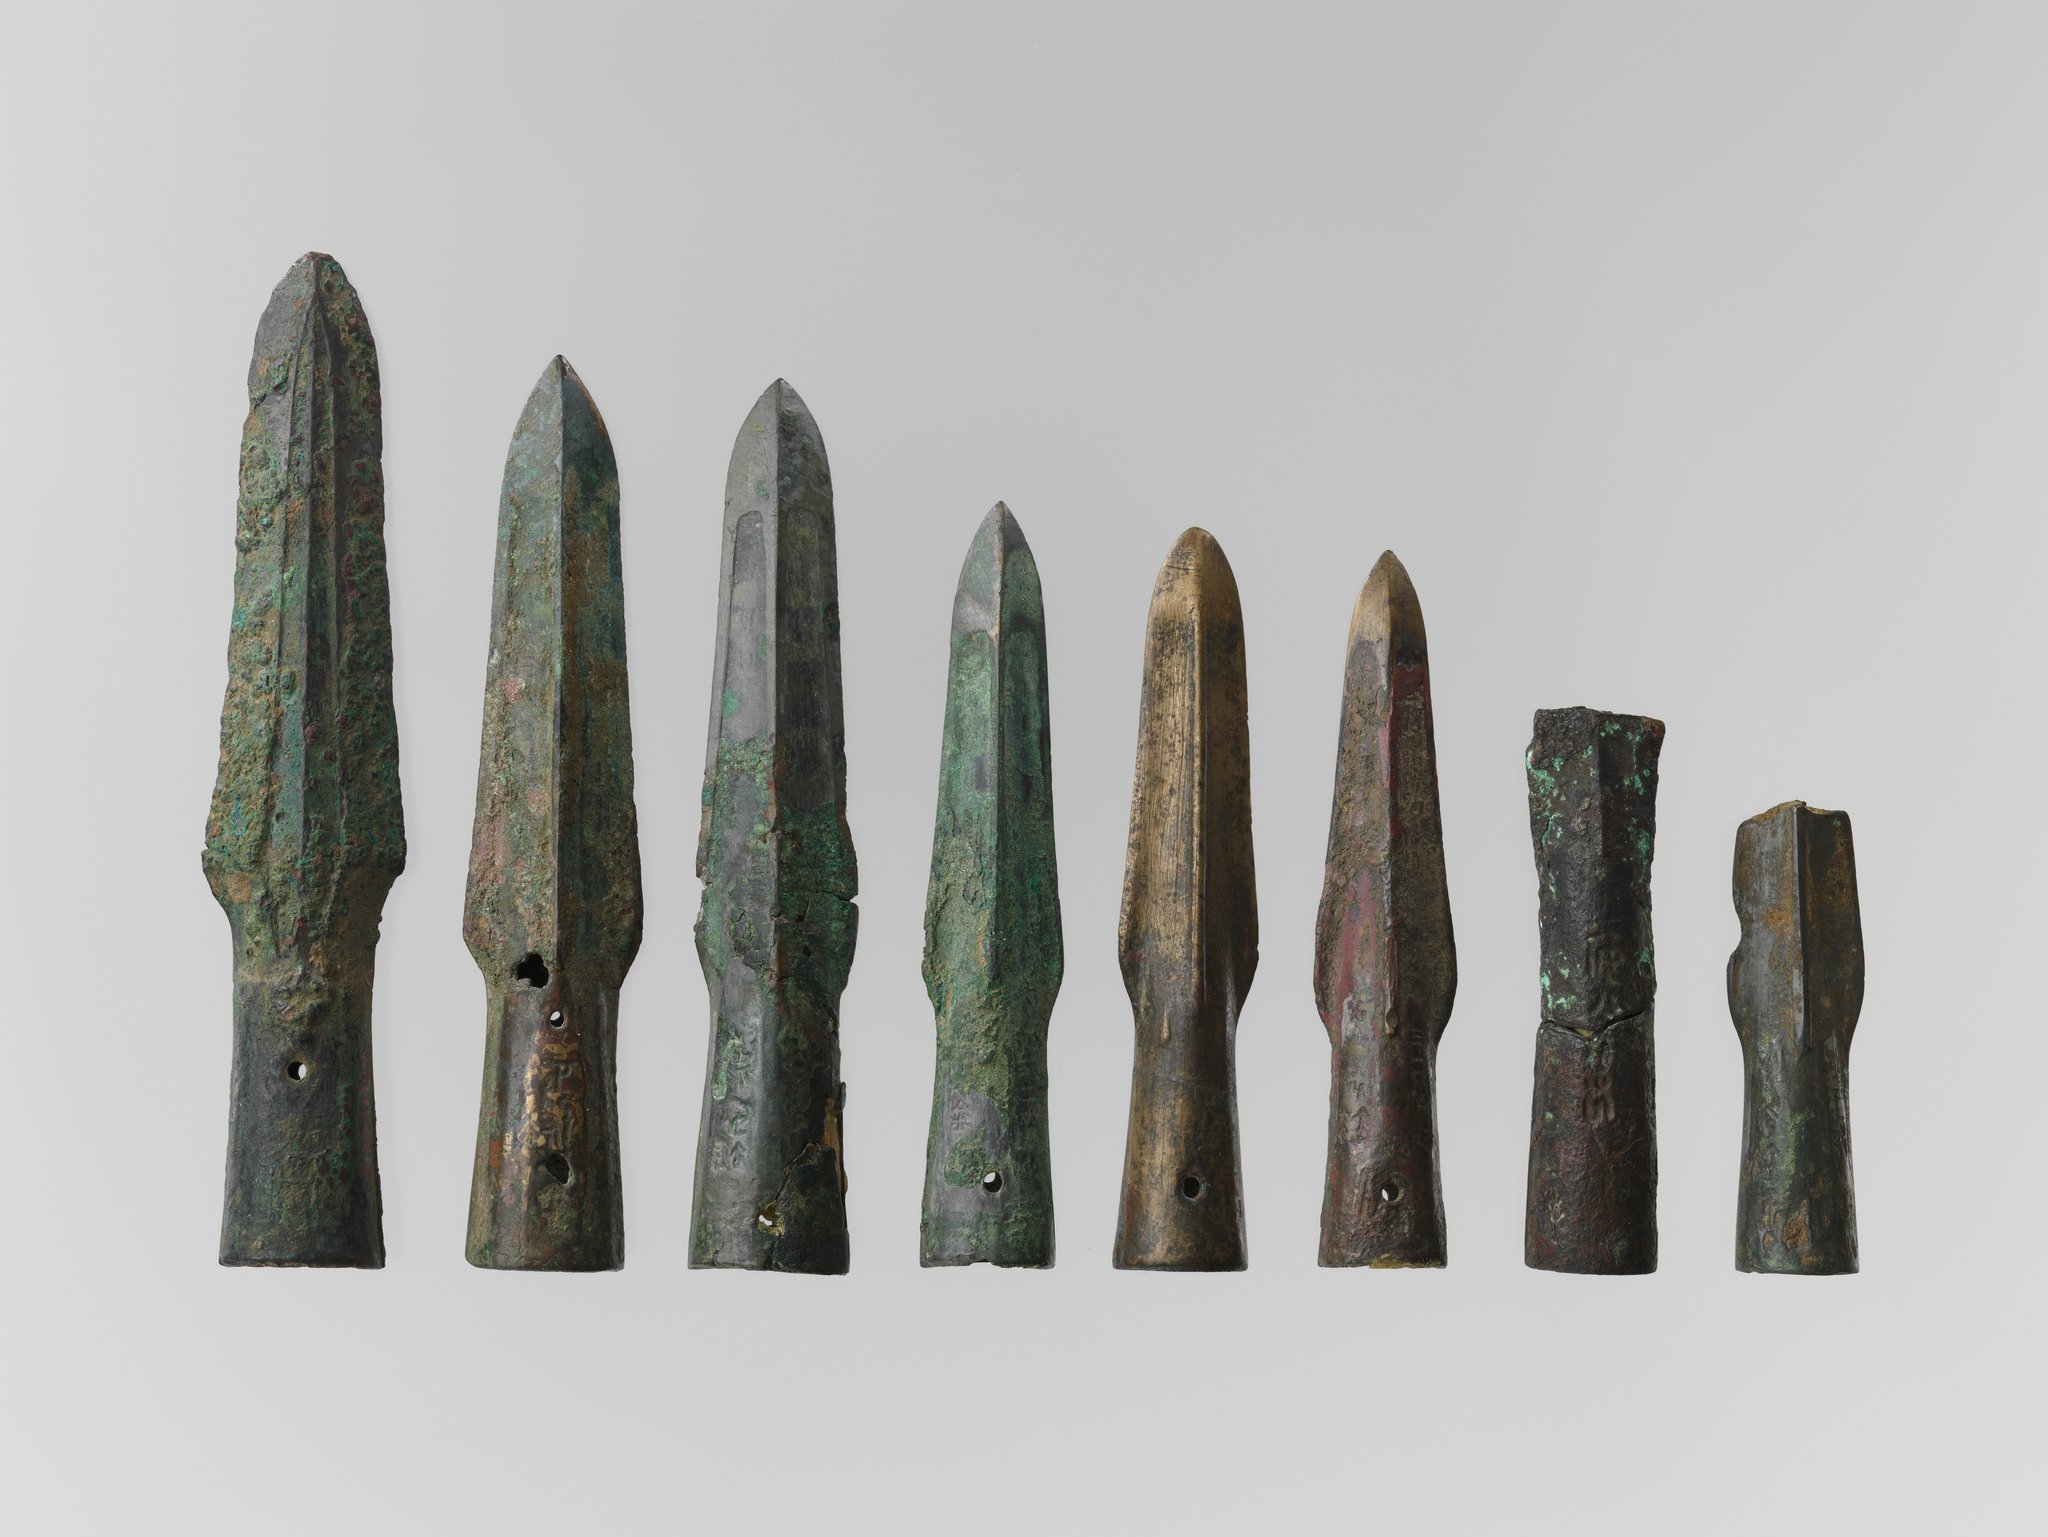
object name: spear head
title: Spear Heads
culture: chinese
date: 1046-256 BCE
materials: bronze